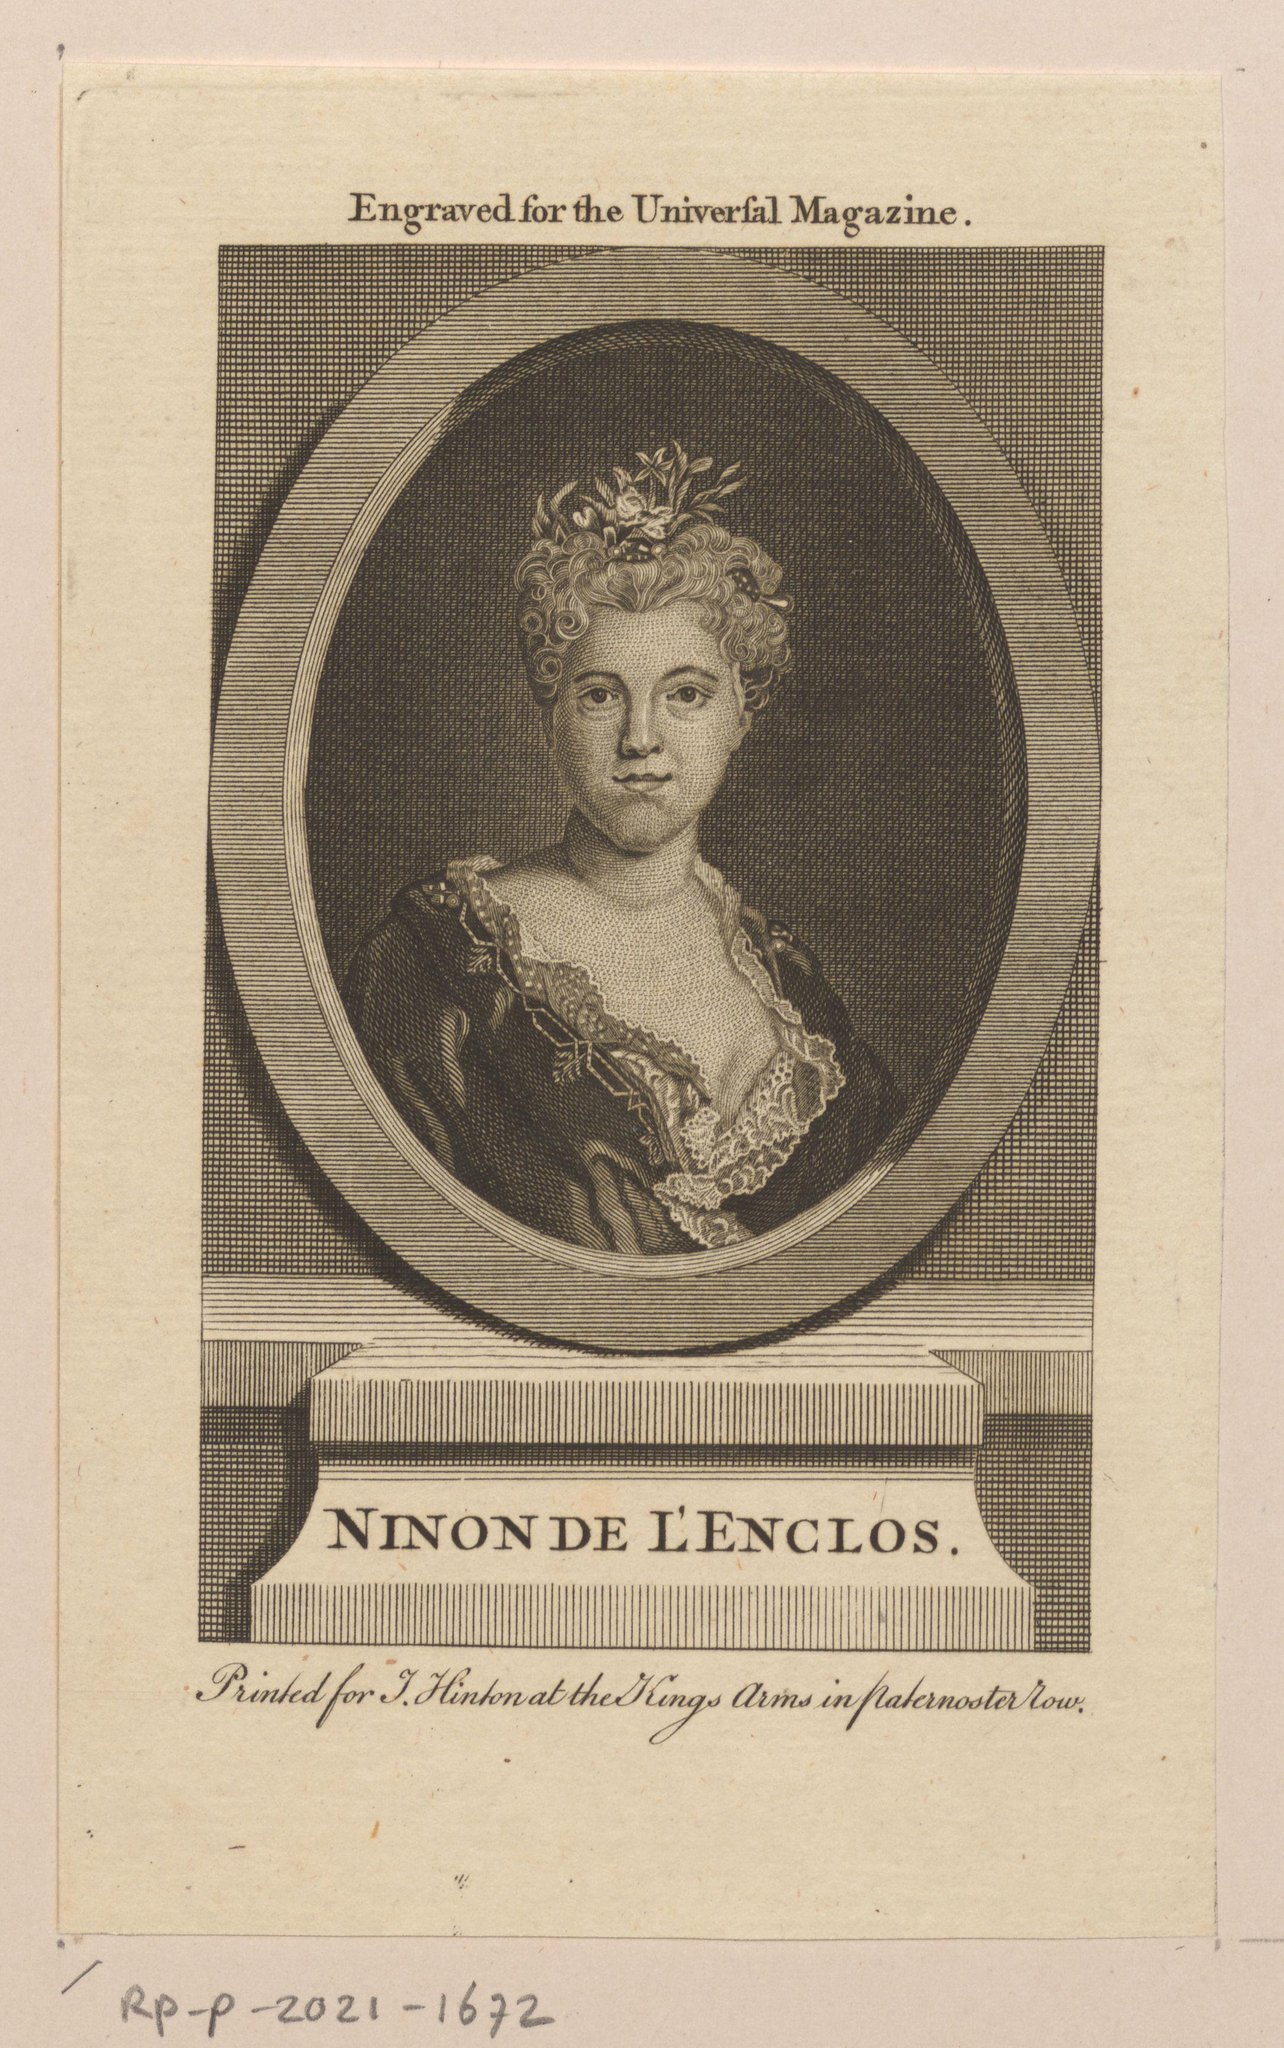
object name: print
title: Portret van Ninon de Lenclos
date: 1747-1781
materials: paper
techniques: engraving, etching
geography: england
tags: paris, historical persons - bb - woman, ornament ~ medallion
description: Prent komt uit een editie van The Universal Magazine.